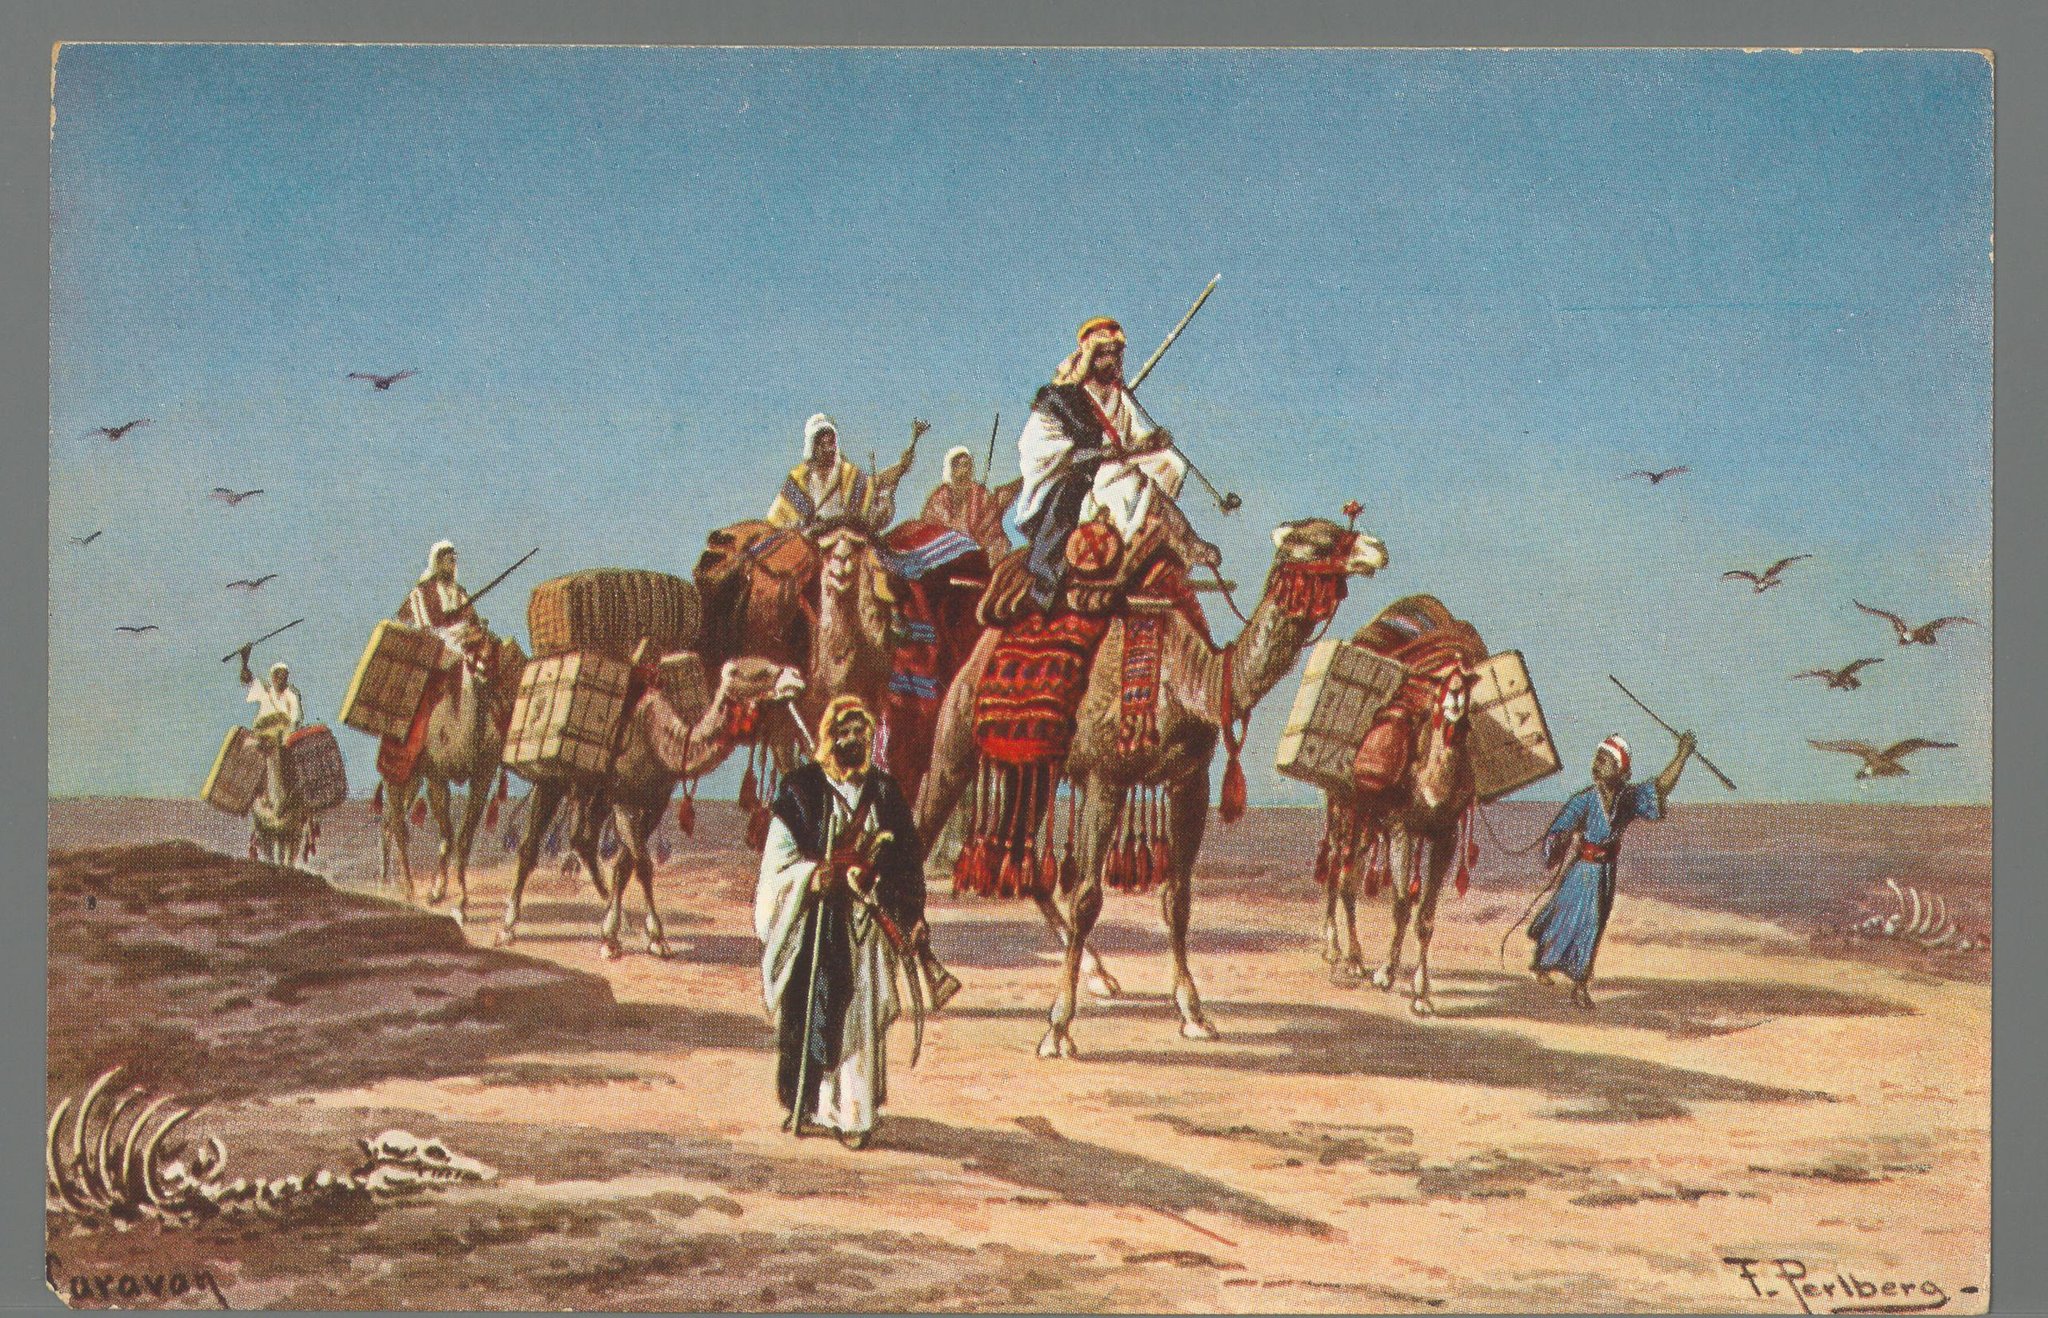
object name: ansichtkaart, prentbriefkaart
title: Caravan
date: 1907-1930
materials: cardboard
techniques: color autotype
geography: munich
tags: hoofed animals: camel, desert, 'en route', traveller under way